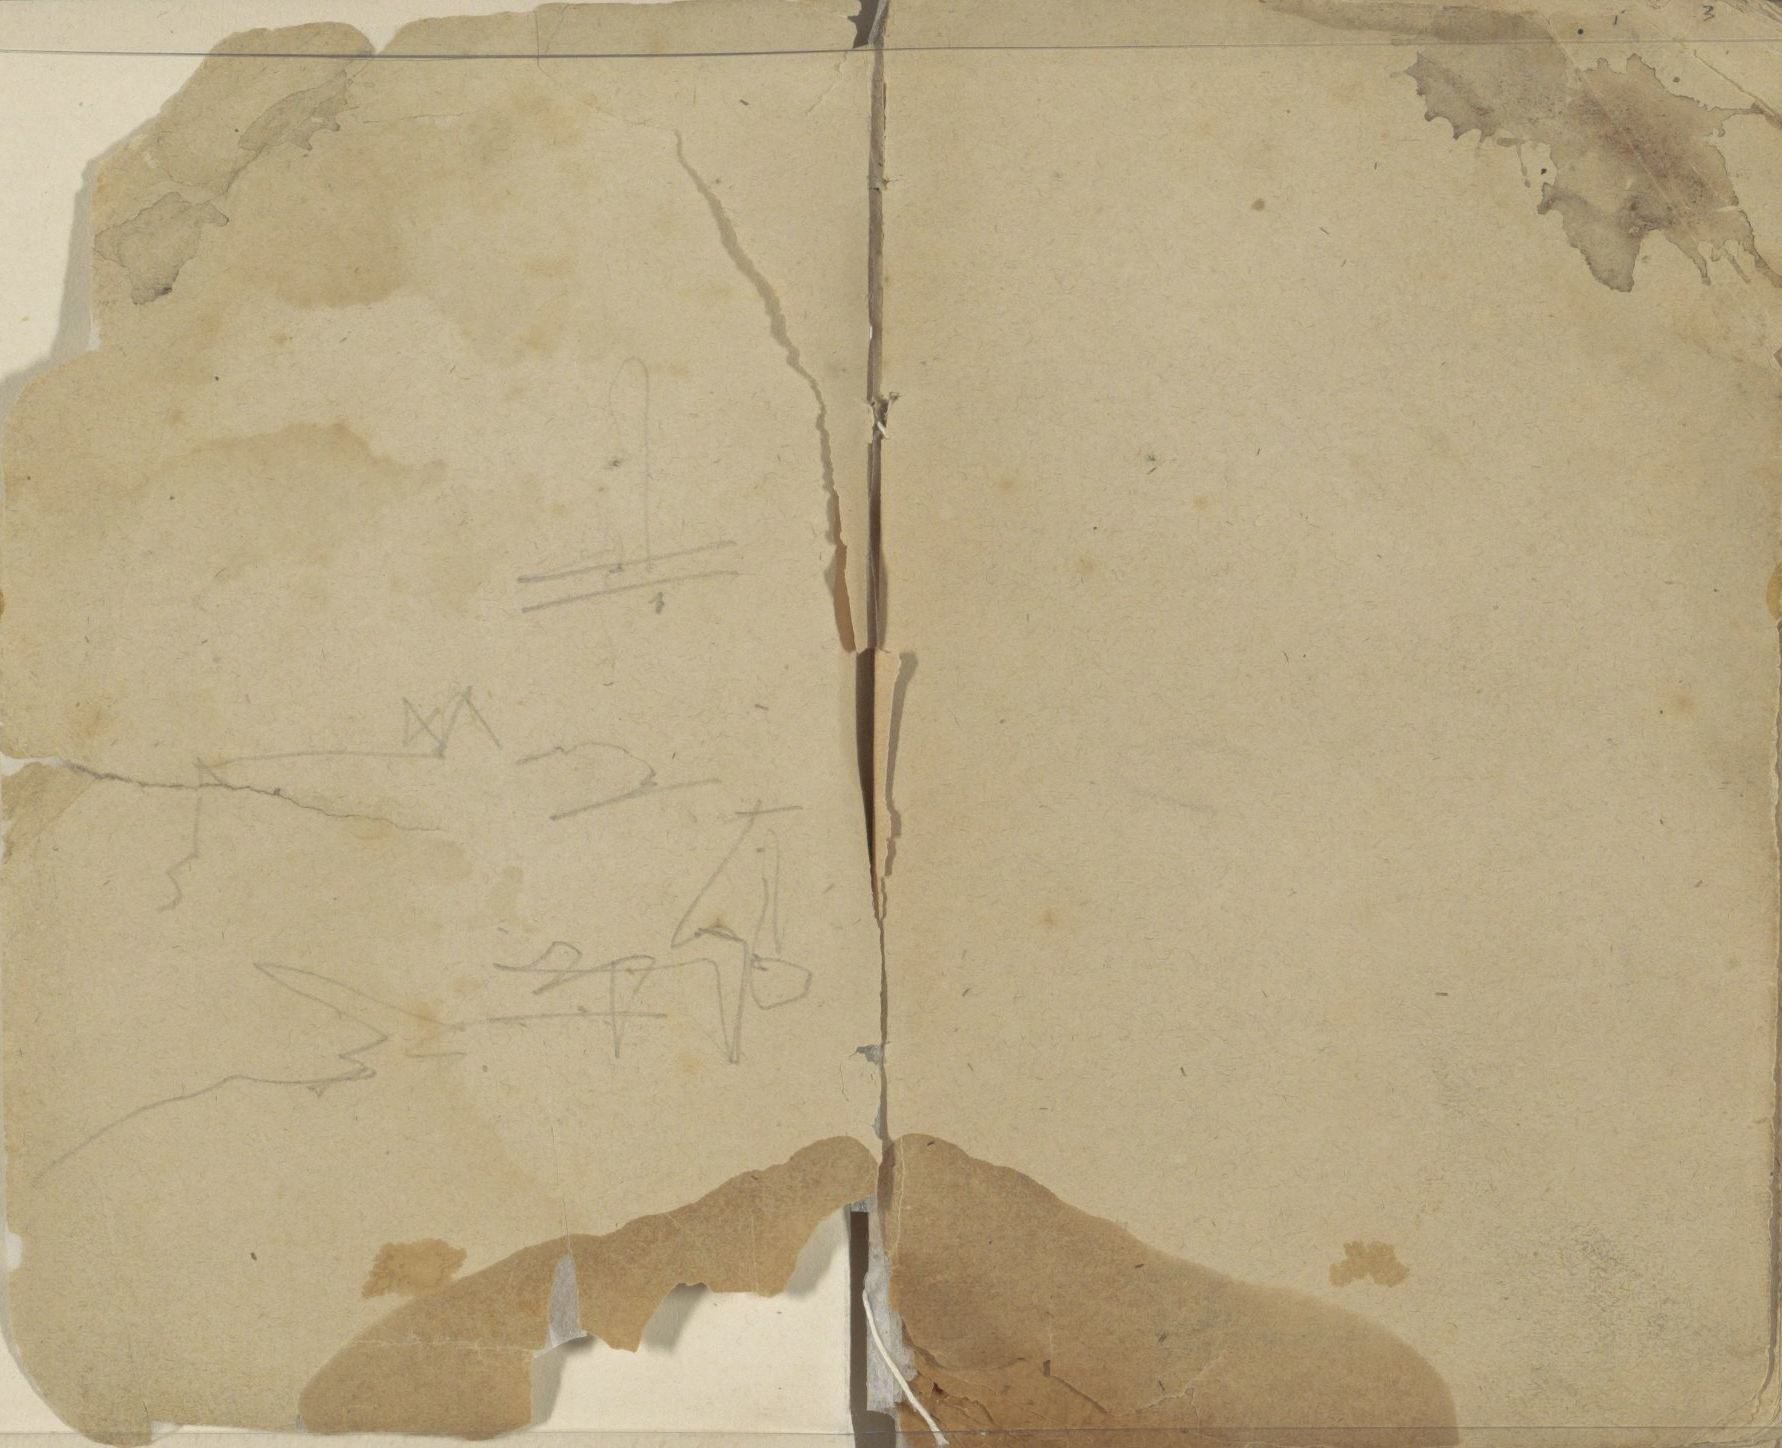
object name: sketchbook leaf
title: Studieblad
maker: george hendrik breitner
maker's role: draughtsman, painter, print maker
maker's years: 1857-1923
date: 1881-1883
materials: paper, pencil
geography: south holland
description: Studieblad. Blad 1 verso uit een schetsboek met 70 bladen.